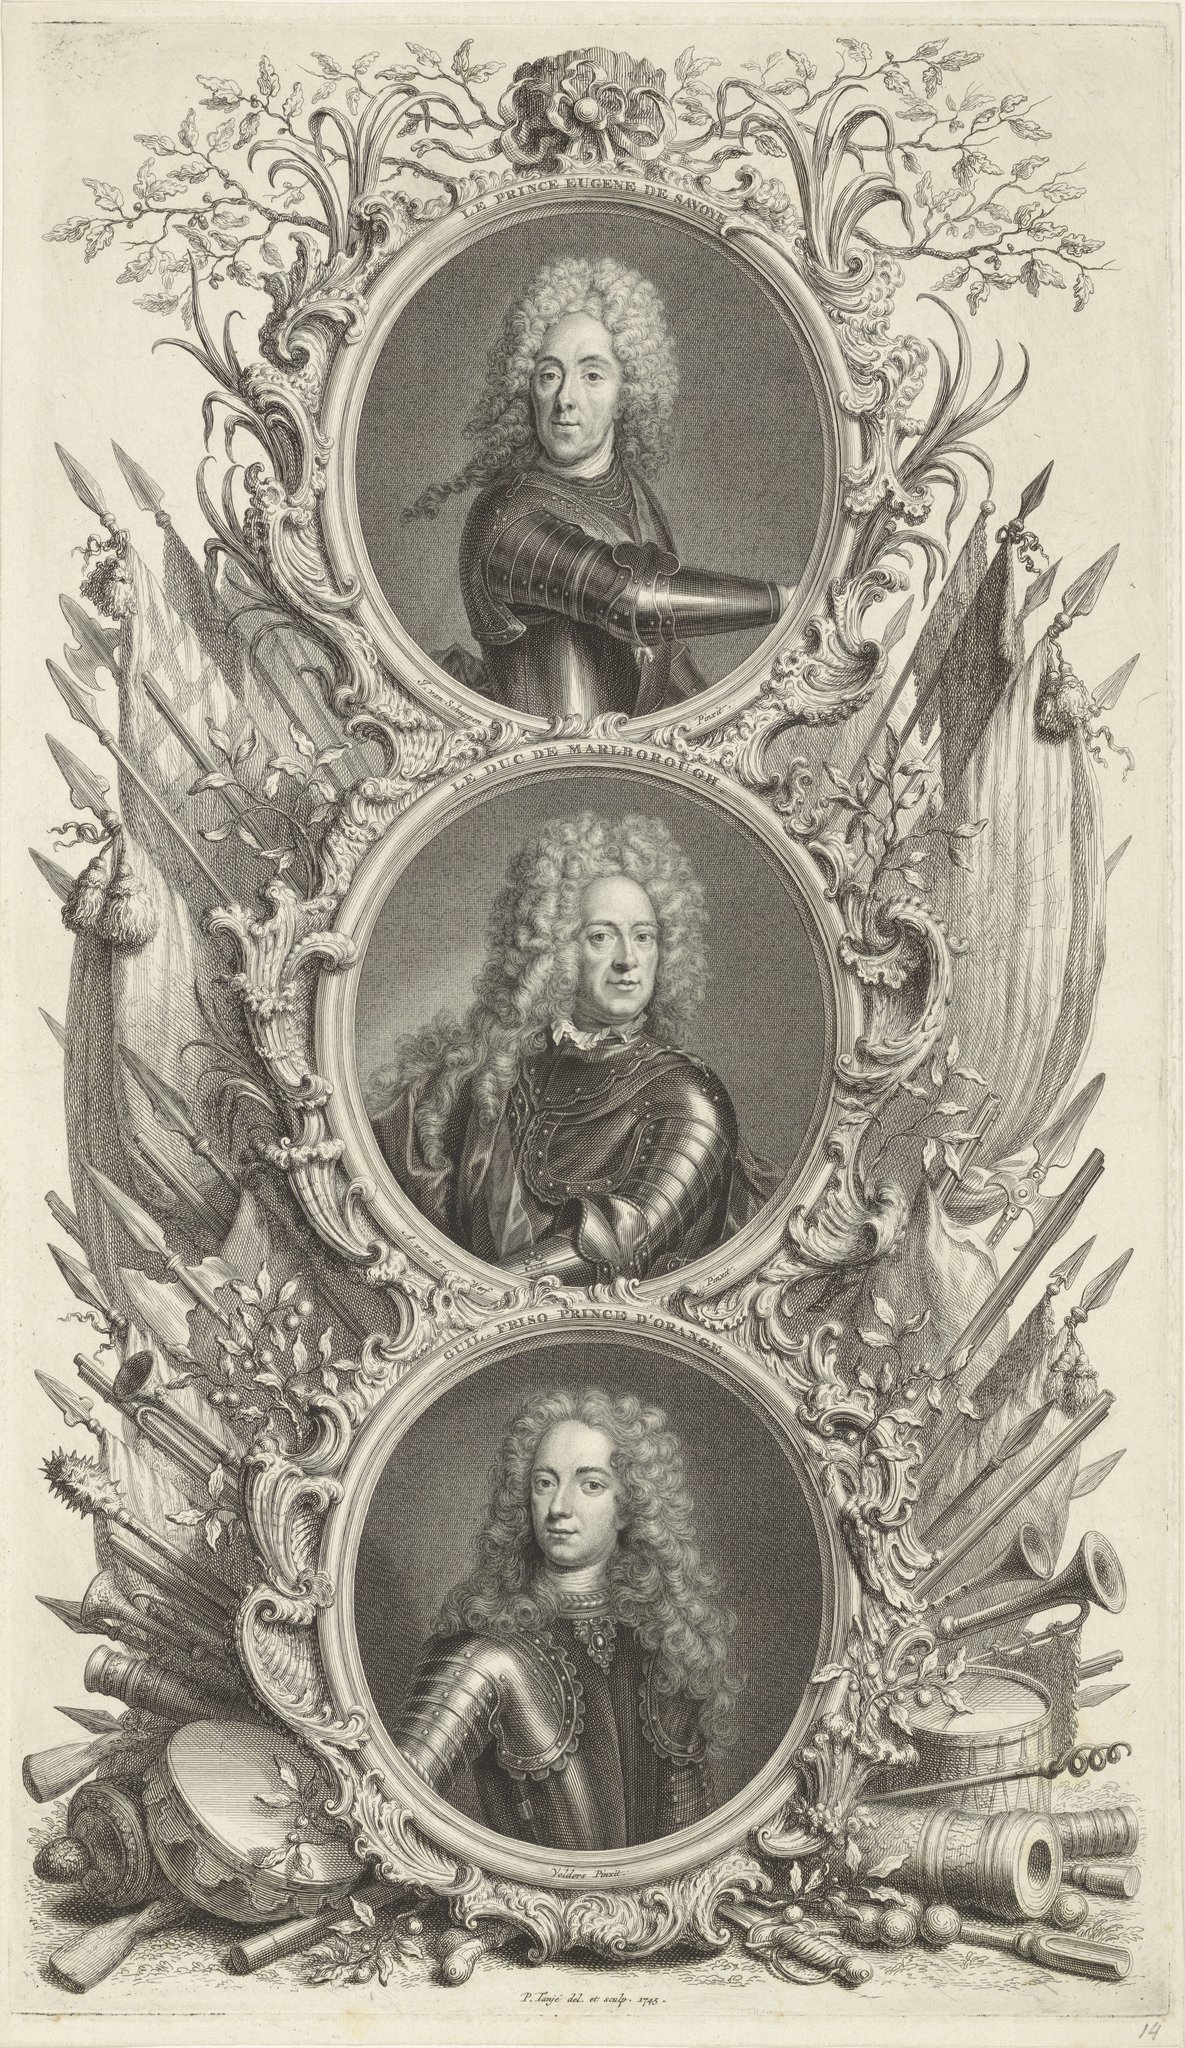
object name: print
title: Portretten van Eugenius van Savoye, hertog John Churchill van Marlborough en Johan Willem Friso, prins van Oranje-Nassau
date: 1745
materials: paper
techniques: engraving, etching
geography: amsterdam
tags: johan willem friso (prins van oranje-nassau), paris, eugenius van savoye, john churchill (1e hertog van marlborough), weapons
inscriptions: collector's mark: Lugt 240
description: Drie portretten onder elkaar van Eugenius van Savoye, hertog John Churchill van Marlborough en Johan Willem Friso, prins van Oranje-Nassau. Zij waren alledrie belangrijke veldheren tijdens de Spaanse Successieoorlog. Rond de portretten militaire attributen als speren, kanonnen, trompetten en banieren.